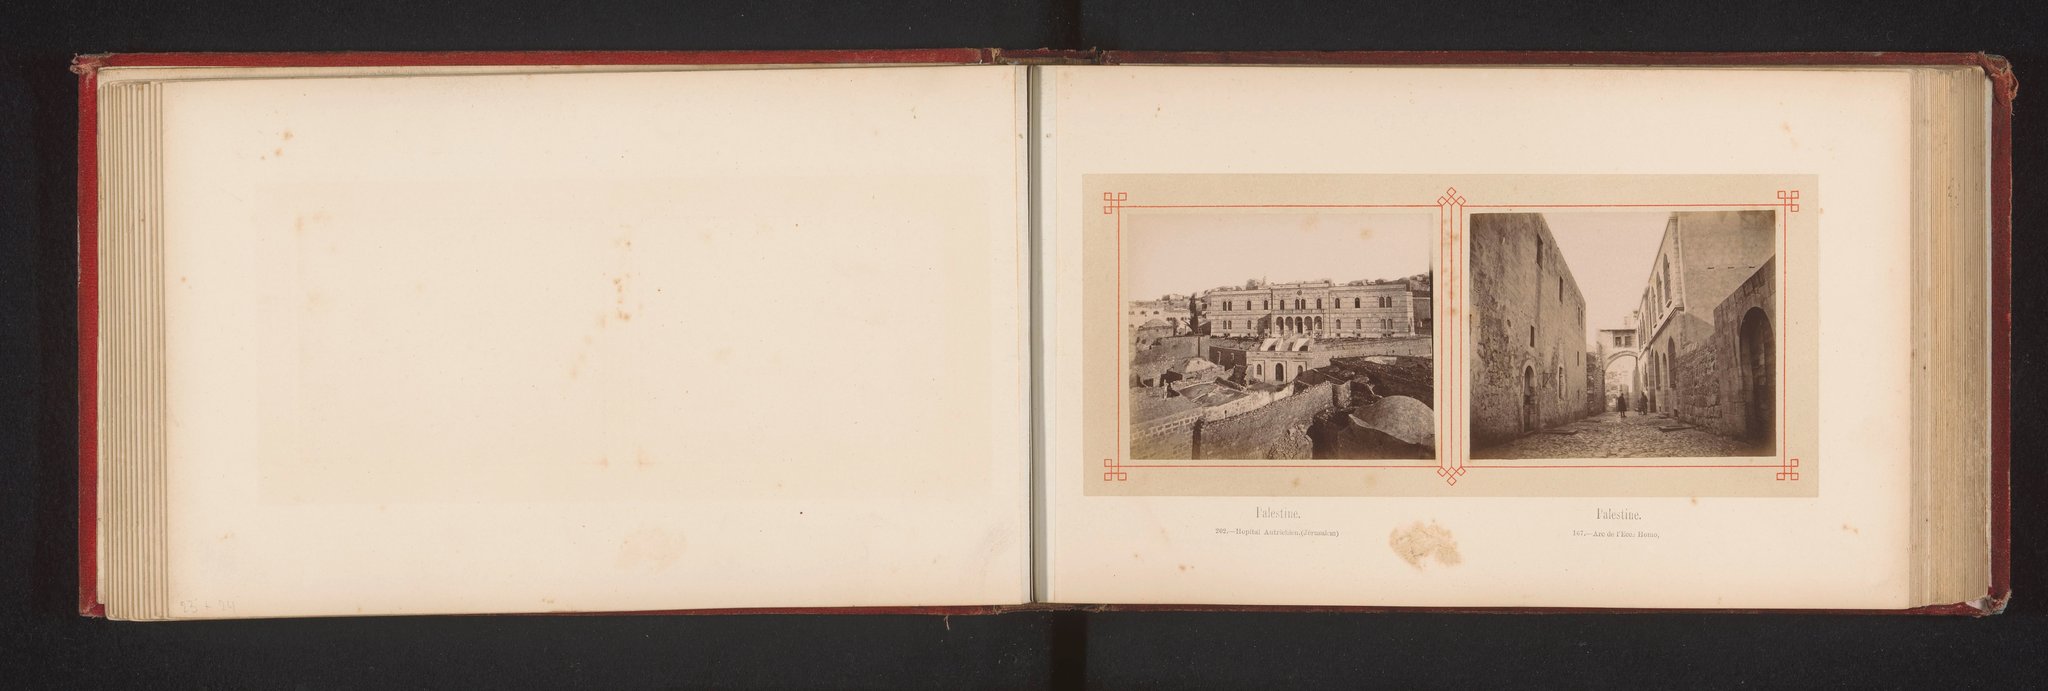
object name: page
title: Palestine - 167.- Arc de l'Ecce Homo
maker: félix bonfils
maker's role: fotograaf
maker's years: 1831-1885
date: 1873-1878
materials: photographic support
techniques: albumen print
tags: arch, archivolt ~ architecture, street